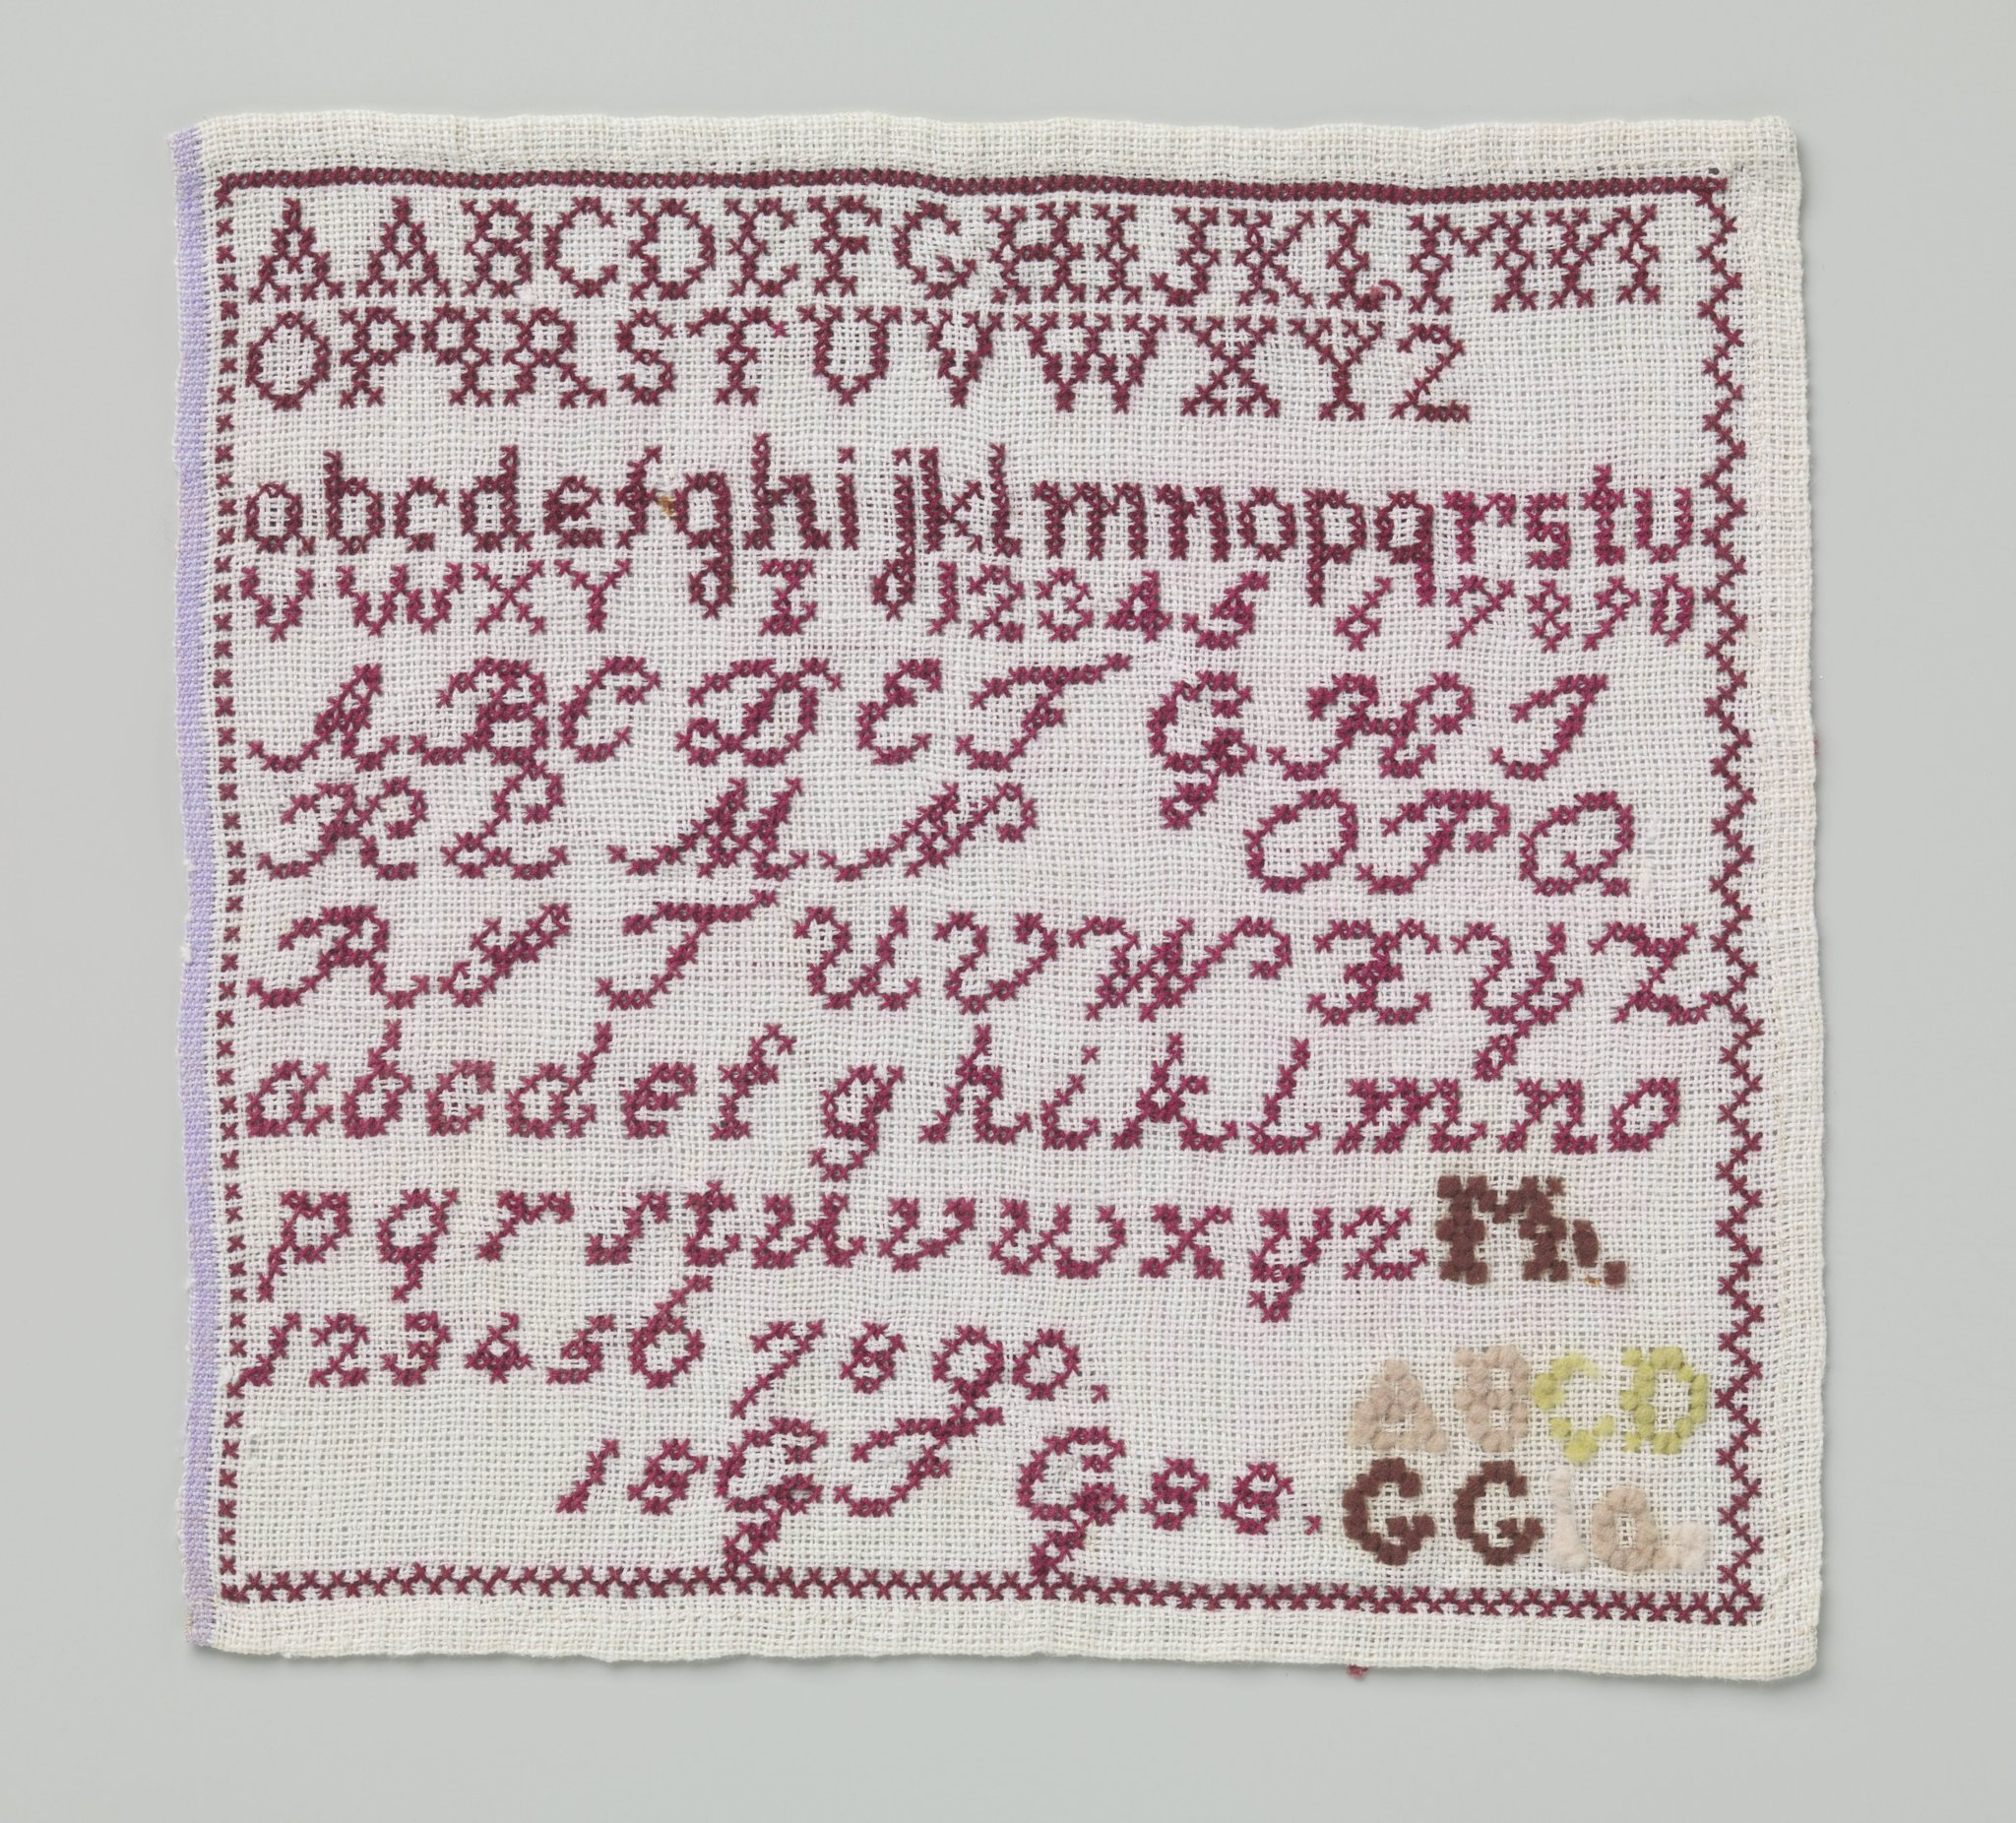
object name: merkdoek, merklap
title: Merklap van linnen met een stramien van rode leters en cijfers, in rood gemerkt: '18GFG88' en in bruin met een wollen draad: 'GG'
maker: g. glas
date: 1888-1894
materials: linen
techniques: embroidered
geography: deventer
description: Vervaardigd op de Normaalschool te Deventer voor de akte 'Nuttige handwerken'.